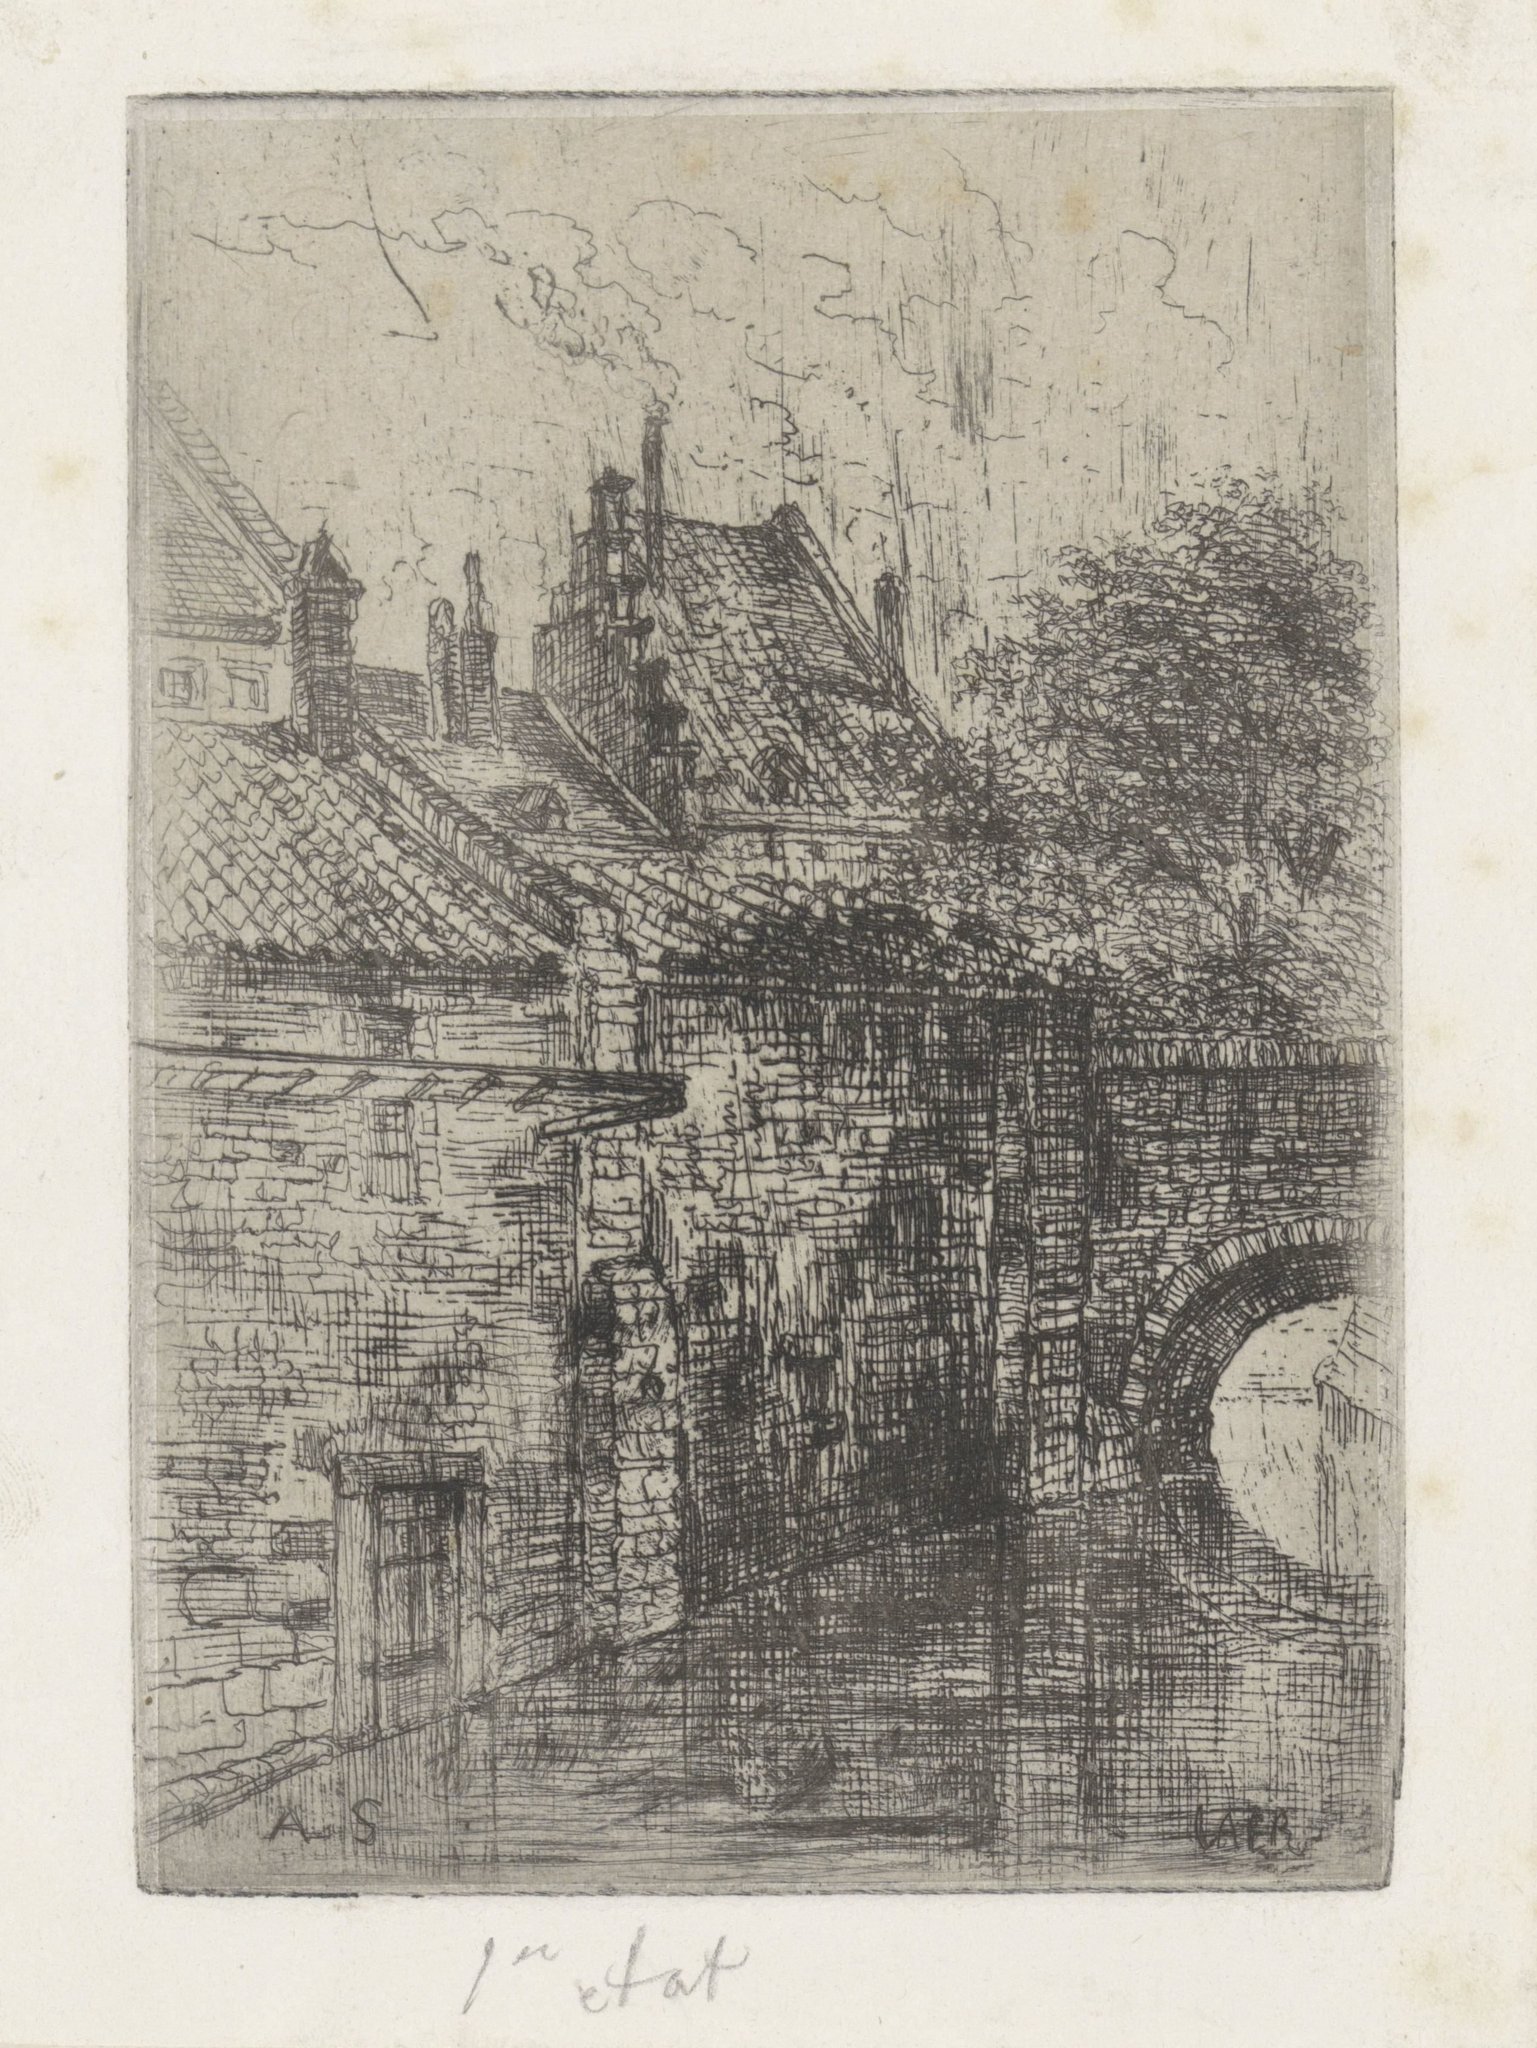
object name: print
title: Jaer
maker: alexander schaepkens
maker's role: draughtsman, print maker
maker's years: 1815-1899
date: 1830-1899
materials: paper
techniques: etching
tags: city-view, and landscape with man-made constructions, bridge, maastricht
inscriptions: collector's mark: Lugt 2228